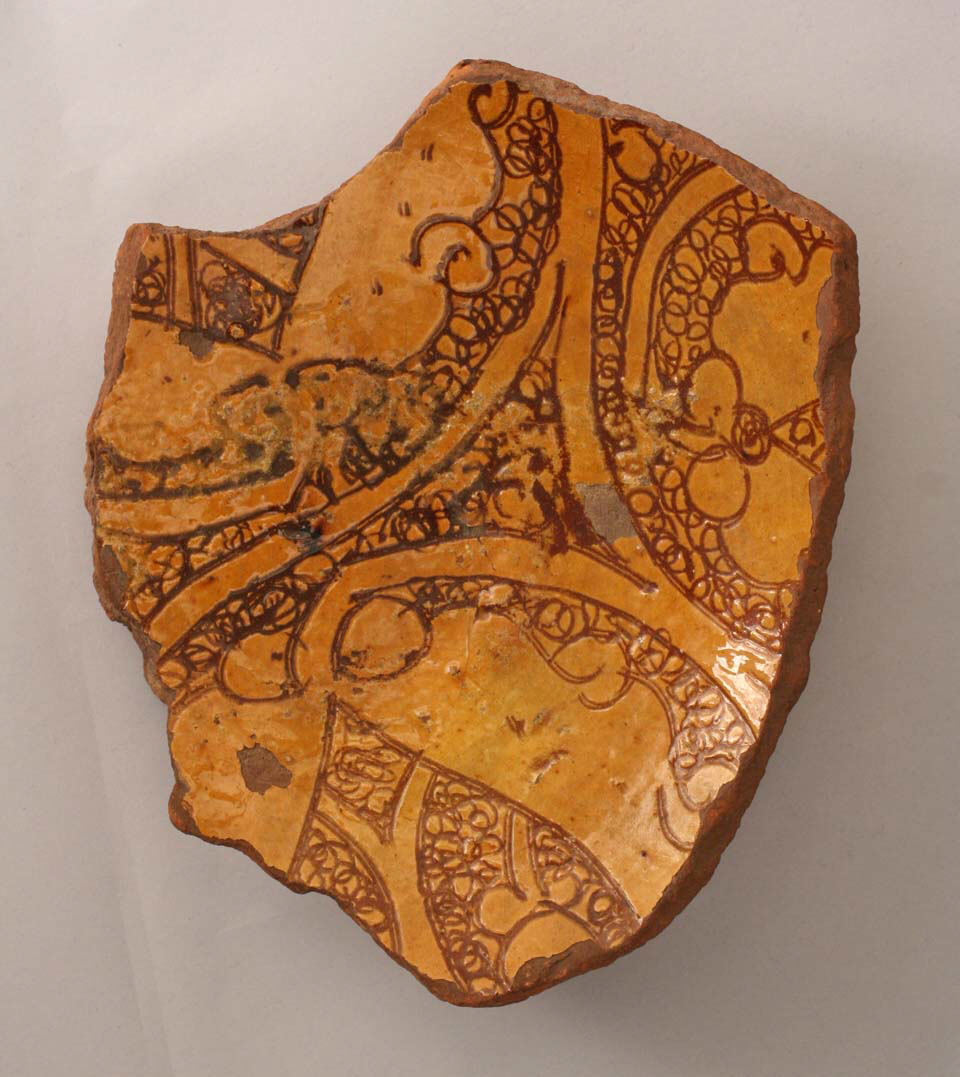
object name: ceramic fragment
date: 1301-1500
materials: earthenware, glaze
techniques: coloring, incising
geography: egypt